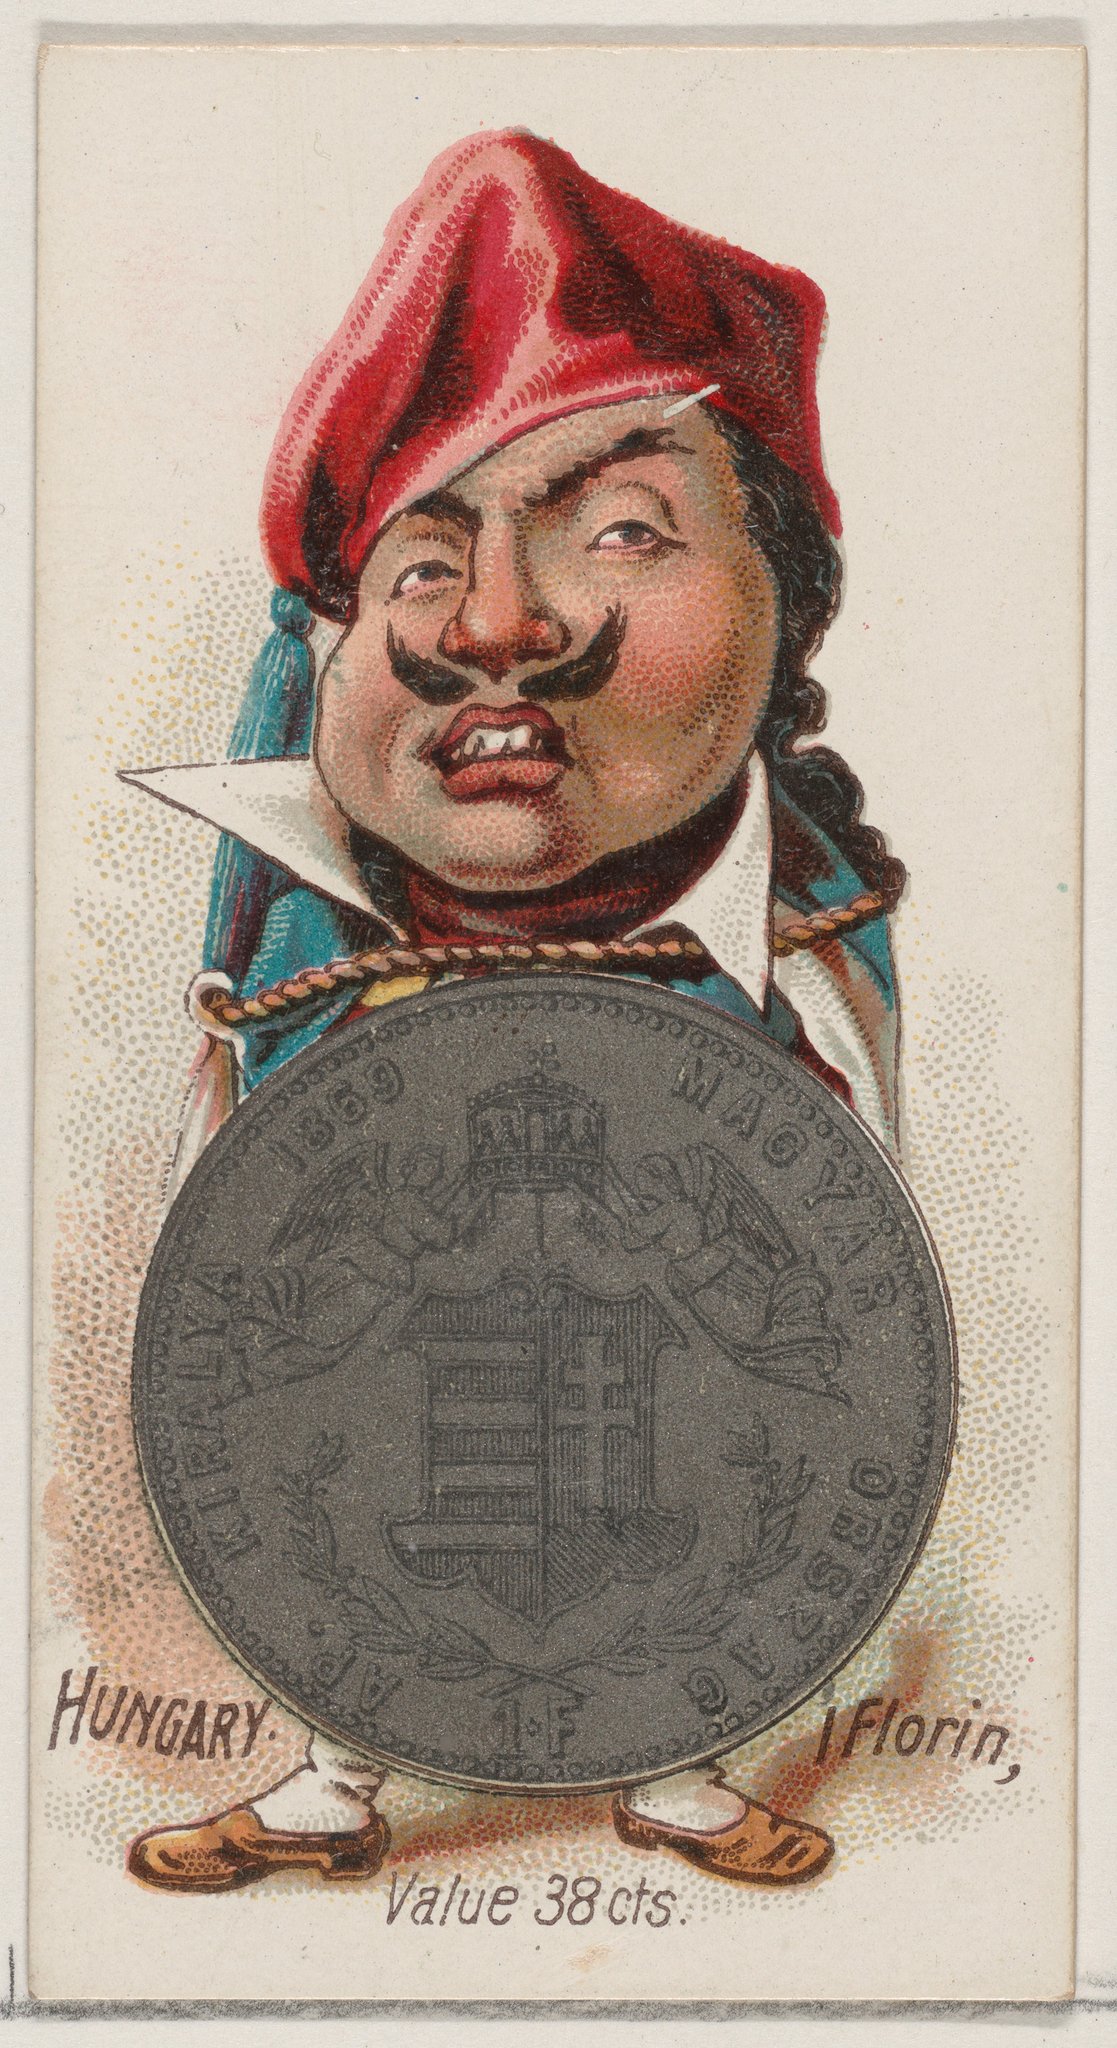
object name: print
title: Caricatured Hungarian, 1 Florin, from the series Coins of All Nations (N72, variation 1) for Duke brand cigarettes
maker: w. duke, sons & co.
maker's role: publisher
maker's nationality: american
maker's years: 1870-1920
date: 1889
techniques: color lithograph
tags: men,coins